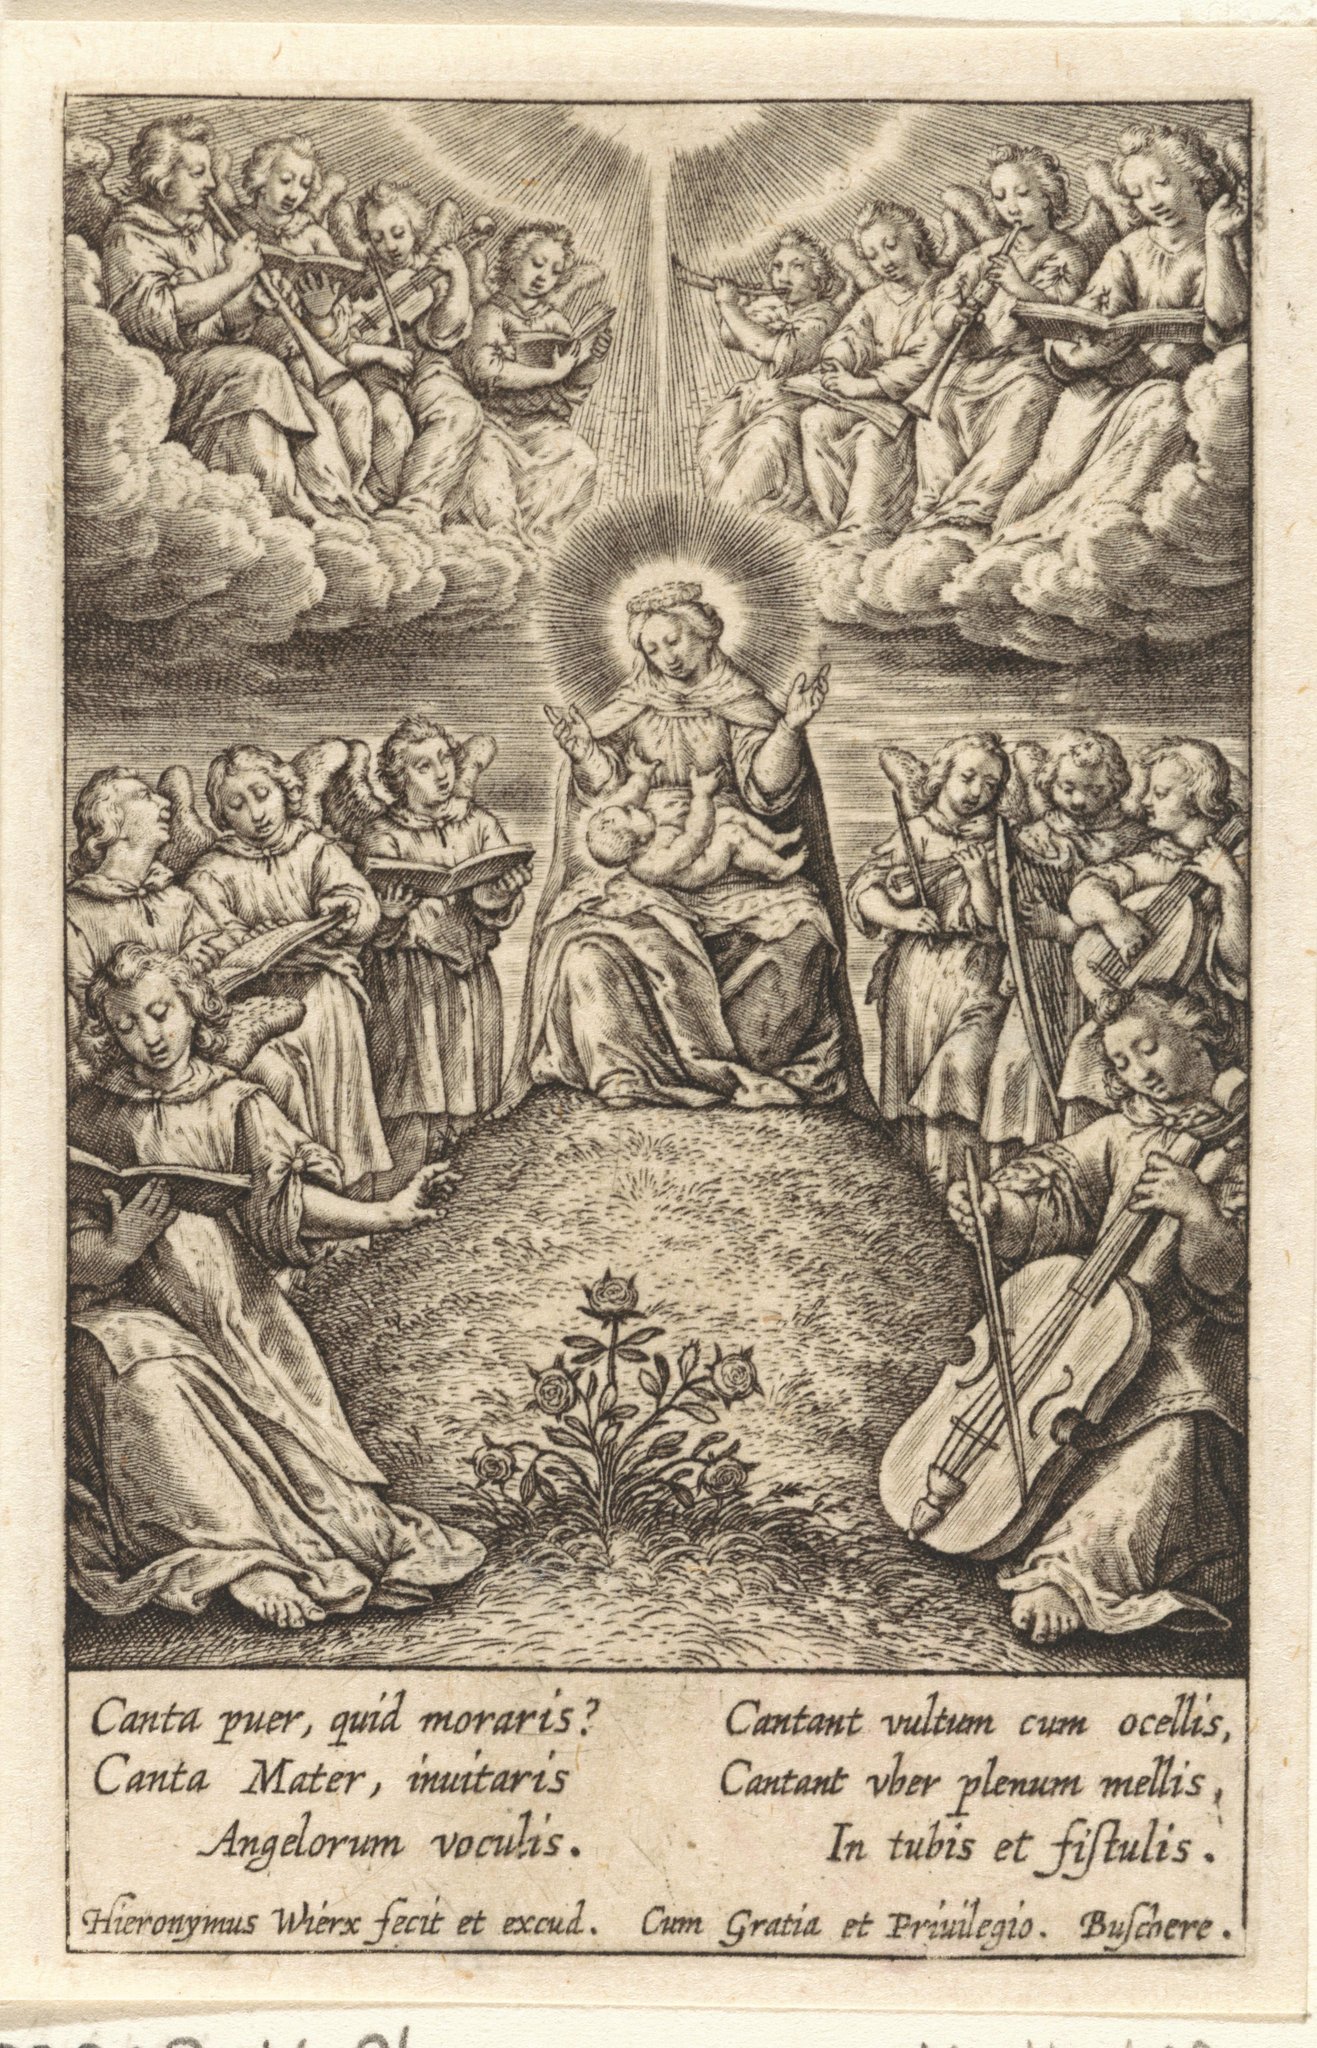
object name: print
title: Iesv Christi dei Domini, salvatoris nri infantia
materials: paper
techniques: engraving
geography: antwerp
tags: mary sitting on the ground, the christ-child in front of her in her lap, angels singing, making music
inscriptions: number: ‘46’, collector's mark: Lugt 240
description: Maria zit met het Christuskind op haar schoot op een heuvel. Ze worden omringd door musicerende en zingende engelen. In de marge een zesregelig onderschrift, in twee kolommen, in het Latijn.